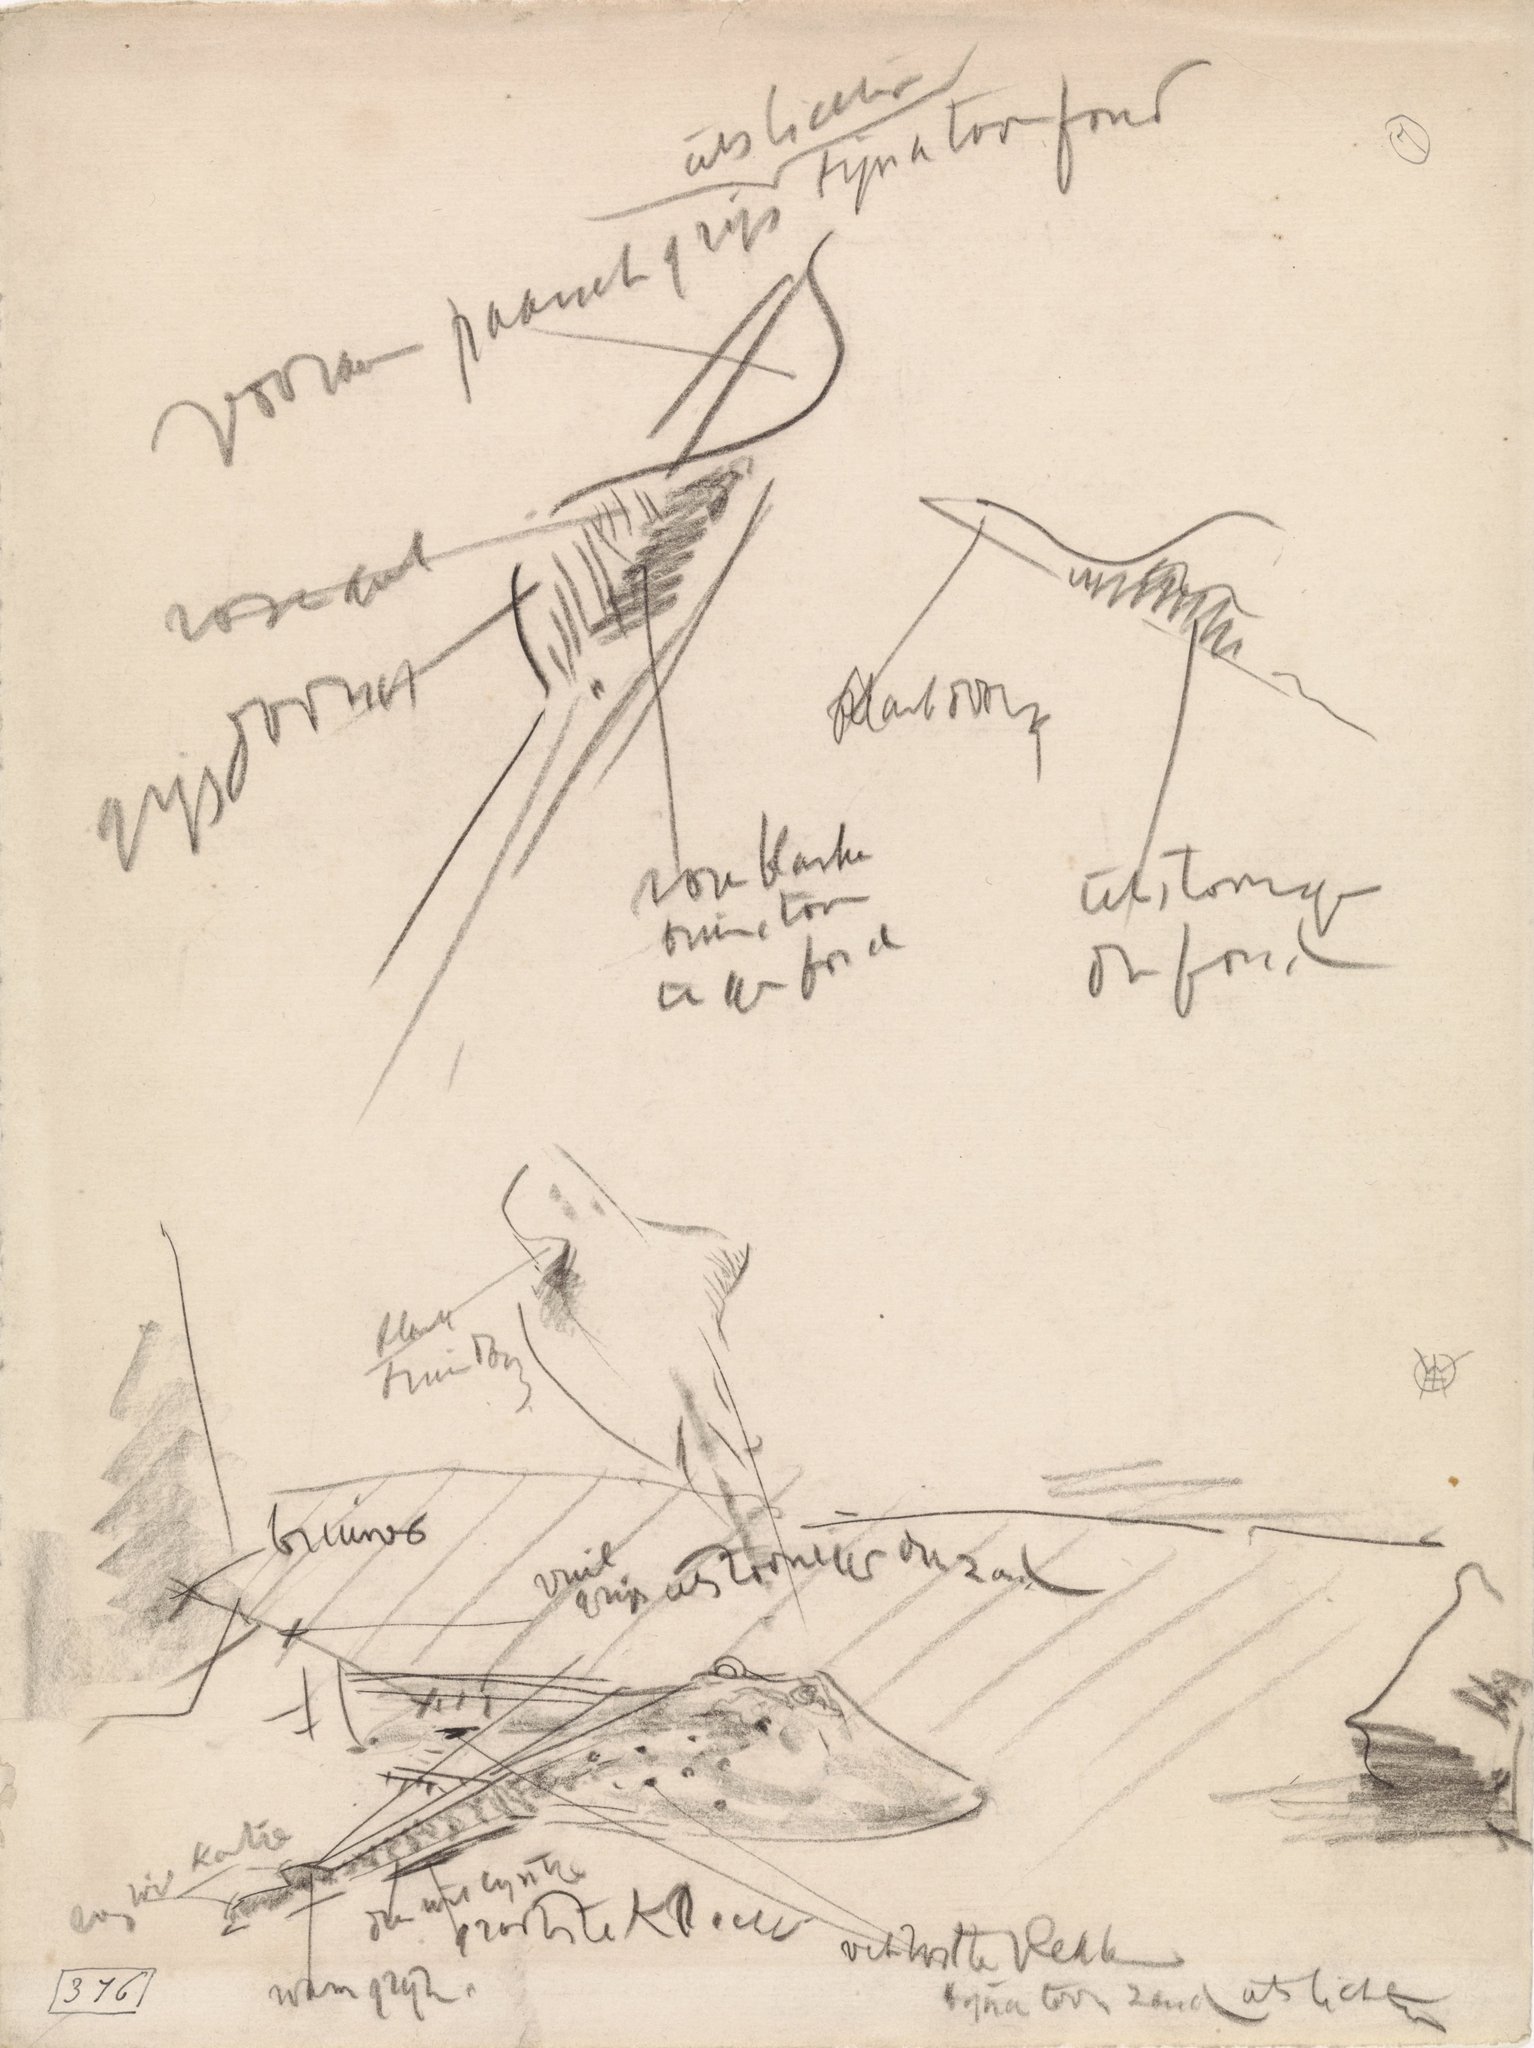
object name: drawing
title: Studies van roggen, met kleurnotities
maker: gerrit willem dijsselhof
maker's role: designer, draughtsman, print maker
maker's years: 1866-1924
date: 1876-1924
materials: chalk, paper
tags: cartilaginous fishes: ray